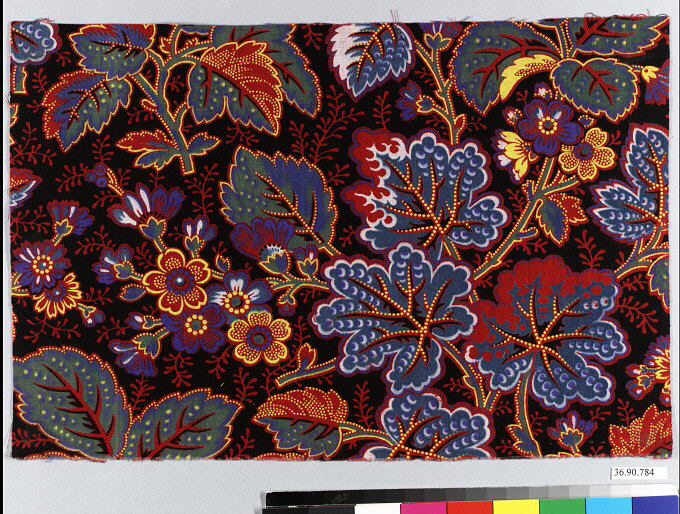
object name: piece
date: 1867-1900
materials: cotton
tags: flowers